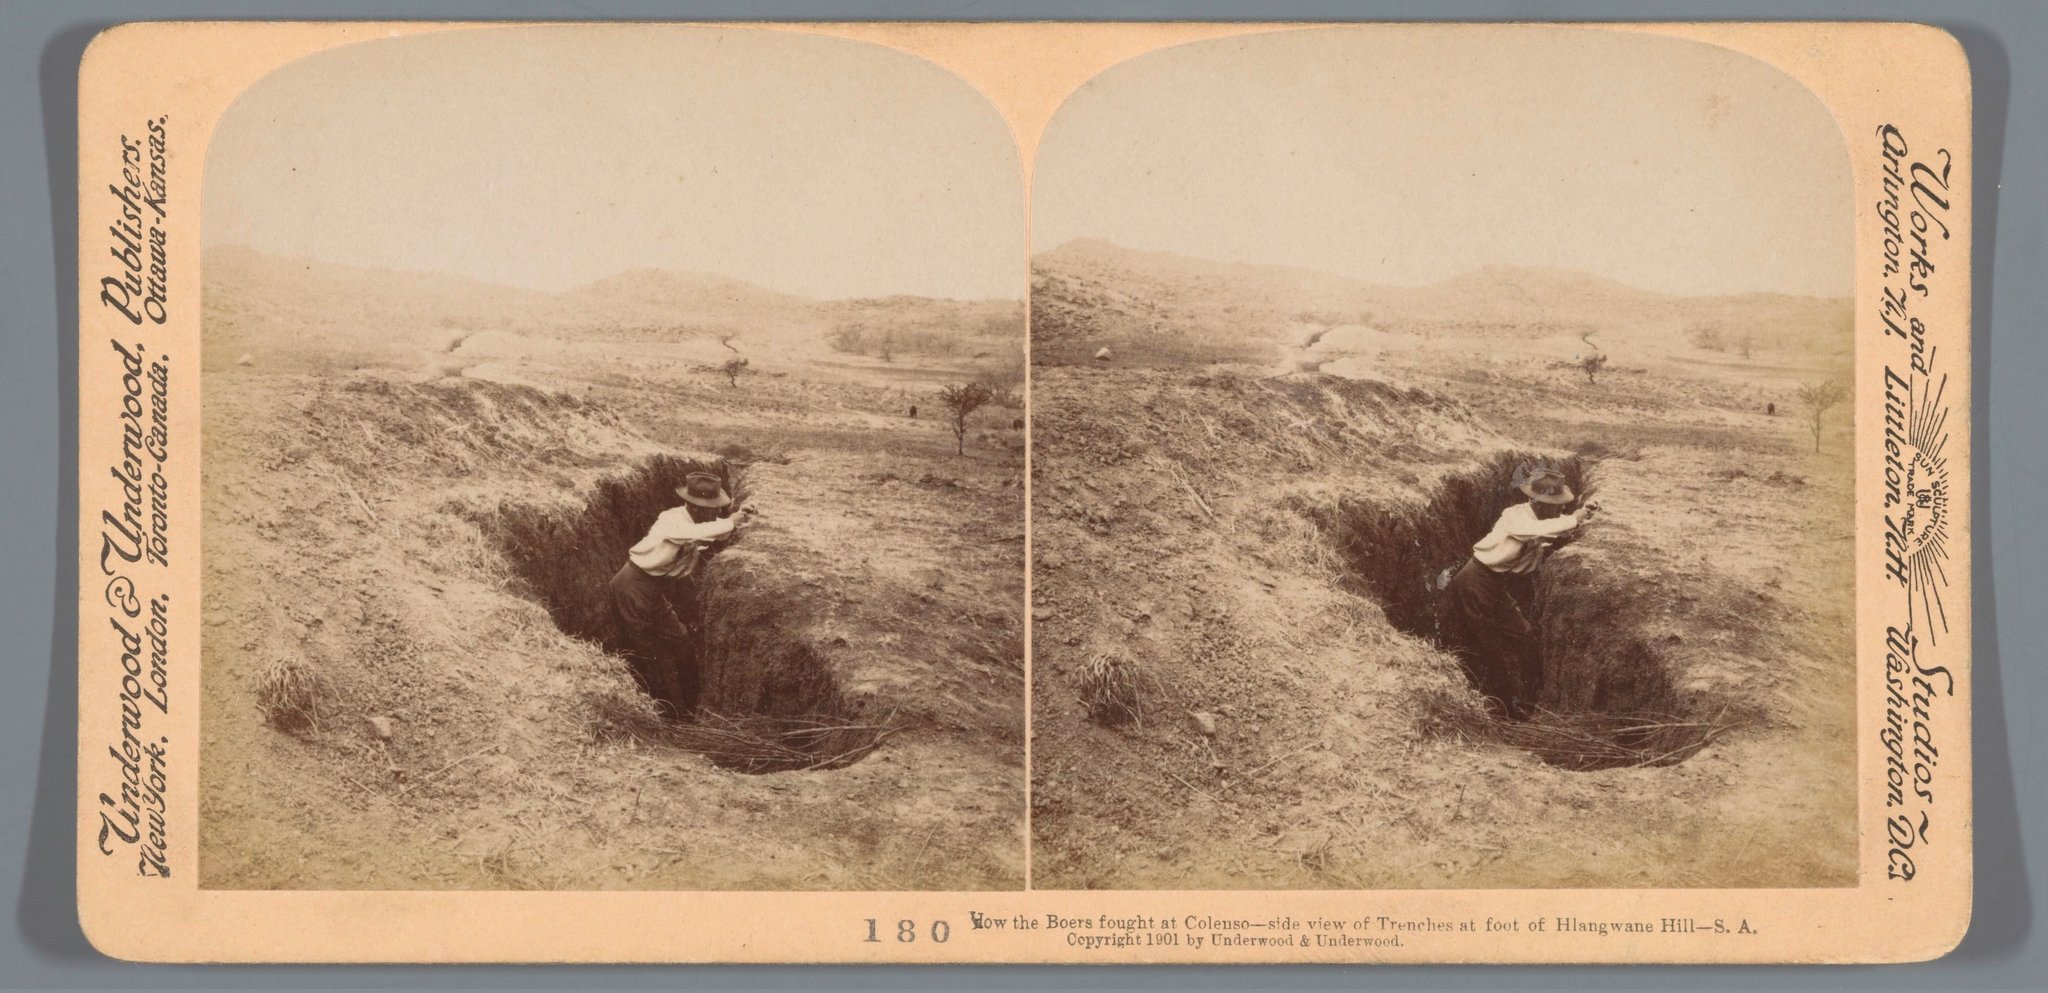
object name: stereograph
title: How the Boers fought at Colenso - side view of Trenches at foot of Hlangwane Hill - S.A.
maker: Anonymous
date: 1901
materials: cardboard, paper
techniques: albumen print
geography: colenso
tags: trenches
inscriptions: inscription, copyright notice: ‘Copyright 1901 by Underwood & Underwood.’, number: ‘180’, inscription: ‘Works and Studios ~/ Arlington, N.J. Littleton, N.H. Washington, D.C.’